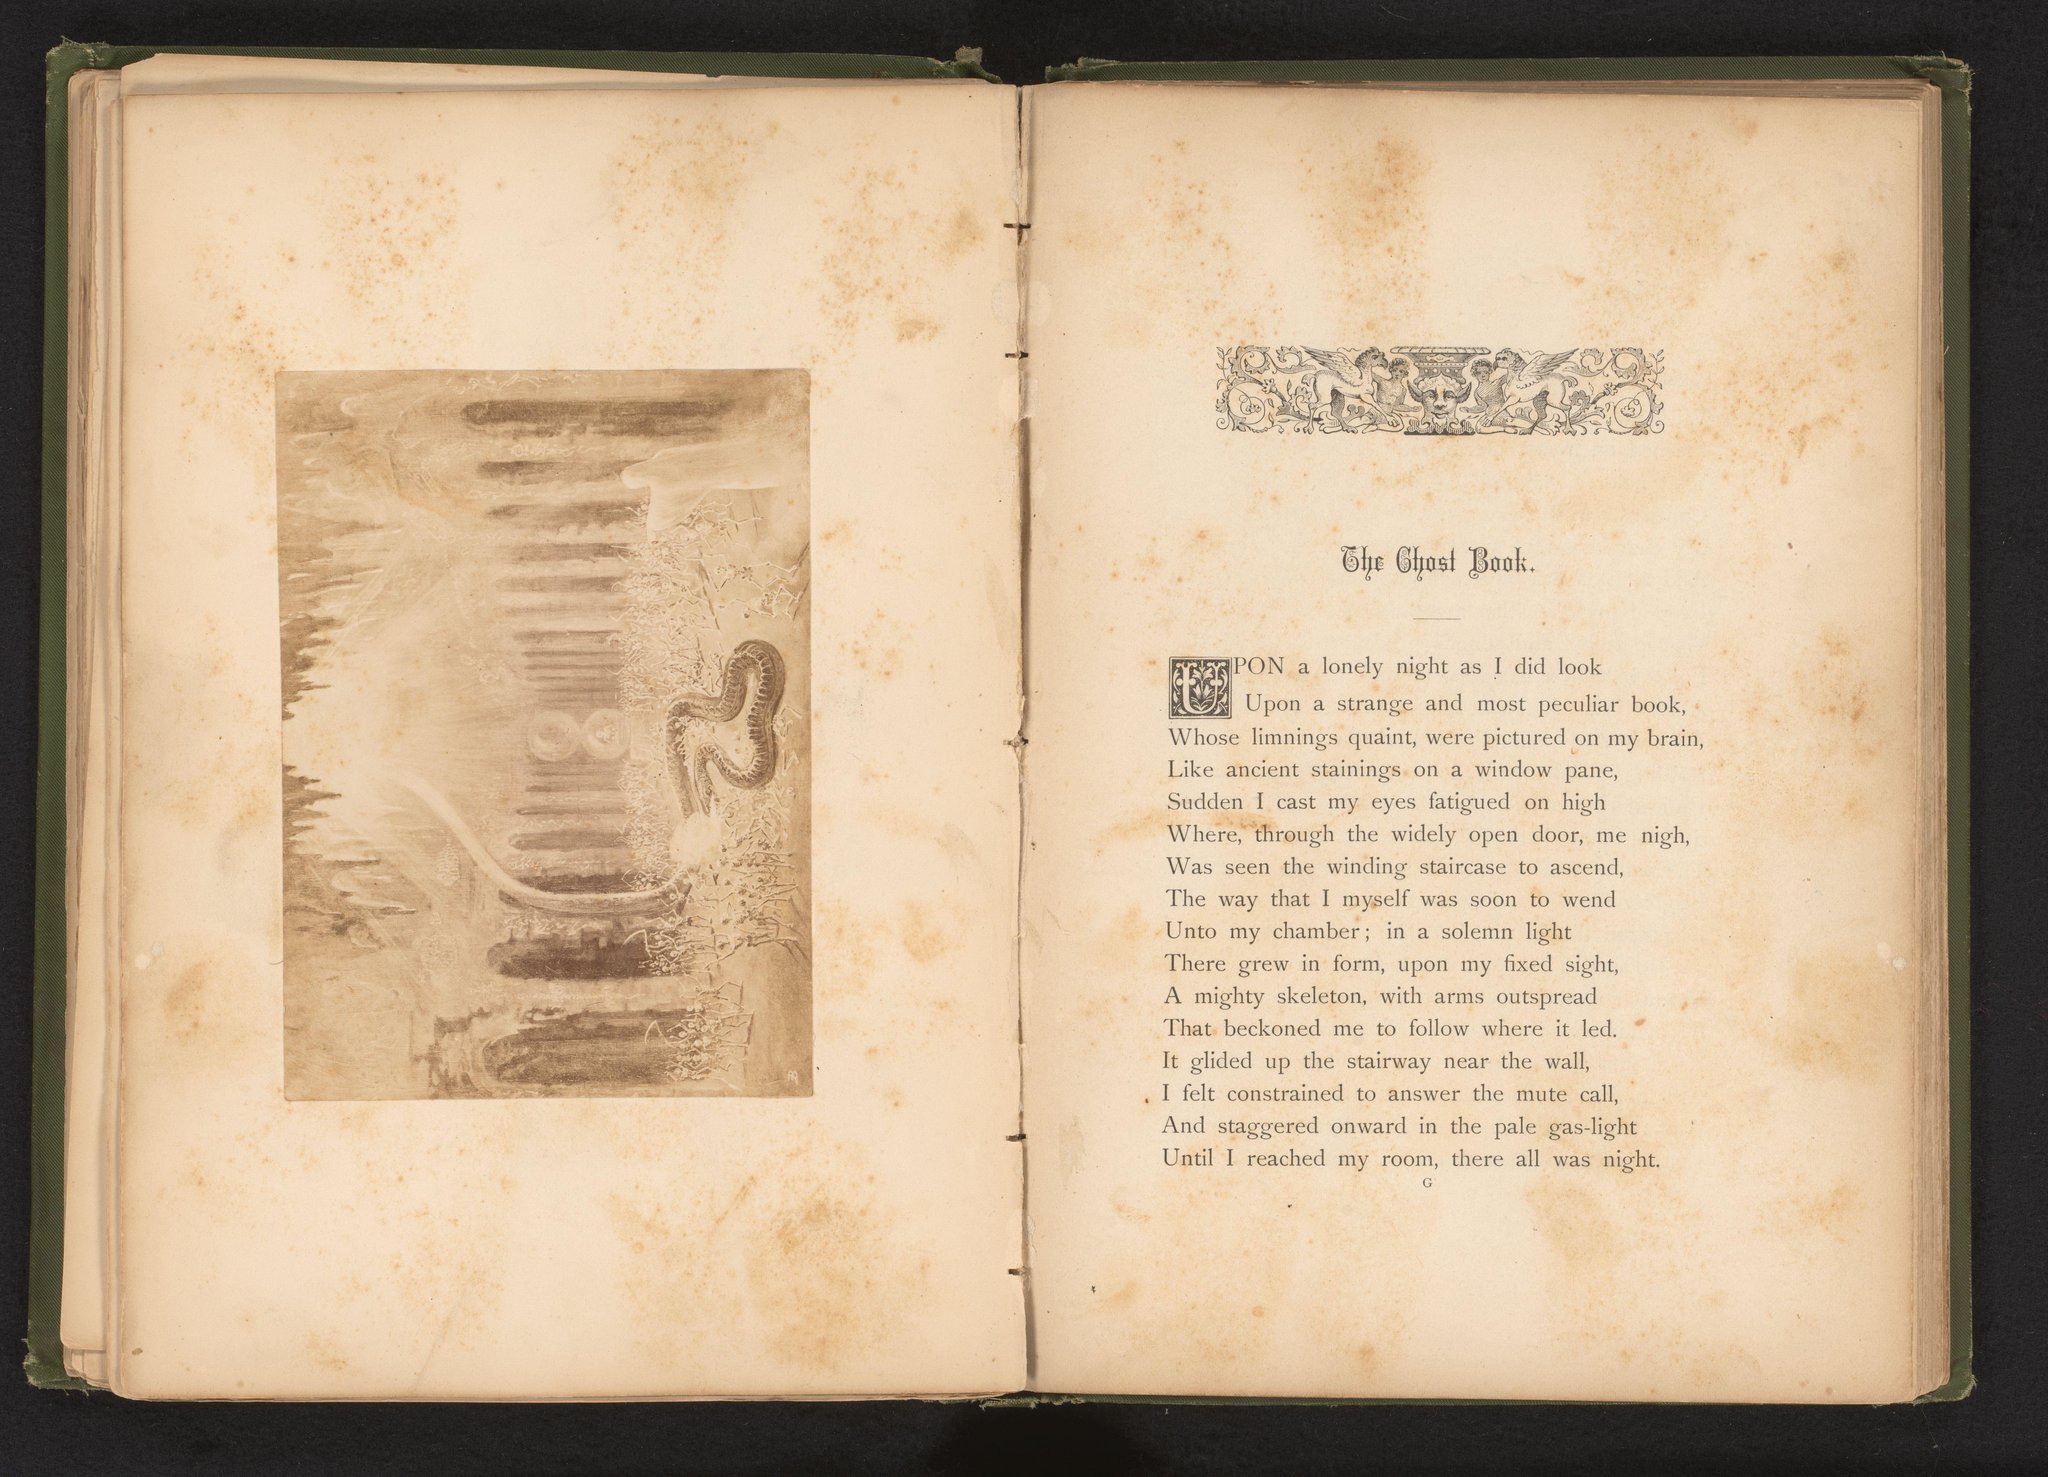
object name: photograph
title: Fotoreproductie van een tekening, voorstellende skeletten rond een slang in (vermoedelijk) een kerk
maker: Anonymous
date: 1871-1876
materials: photographic support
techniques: albumen print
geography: united states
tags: snakes, interior of church, (human) skeleton